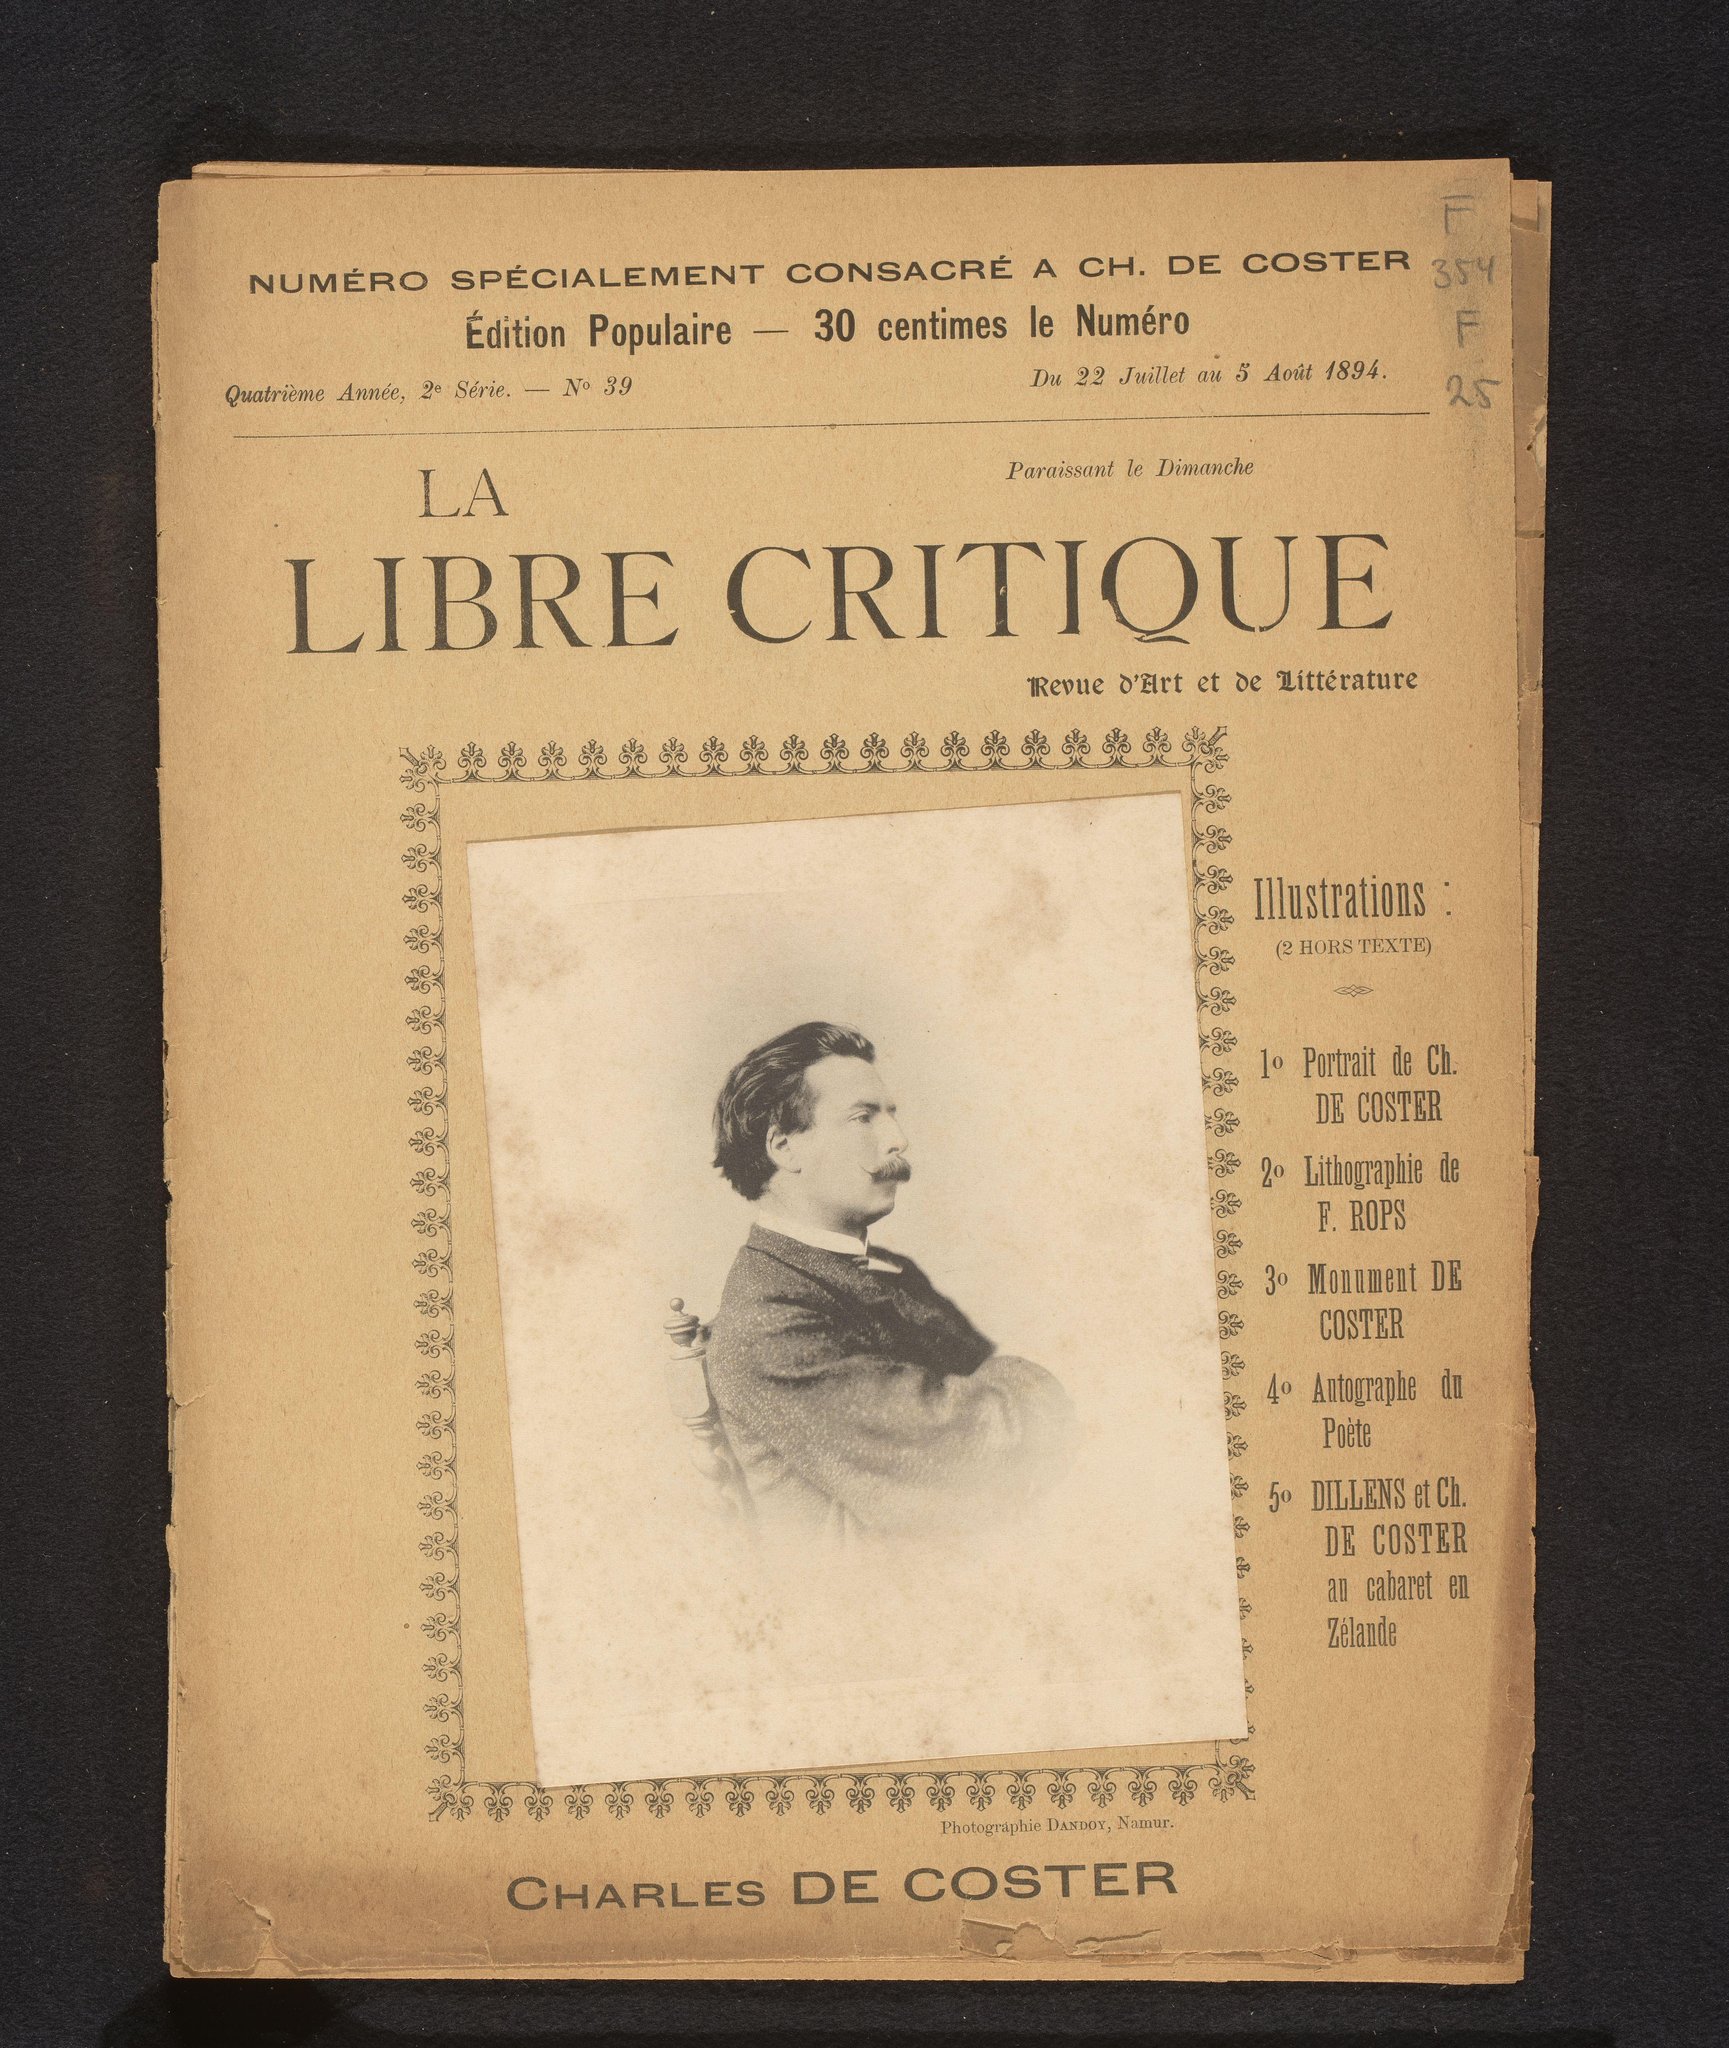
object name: page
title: Charles De Coster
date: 1884-1894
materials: paper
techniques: photograph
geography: namur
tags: portrait of a writer